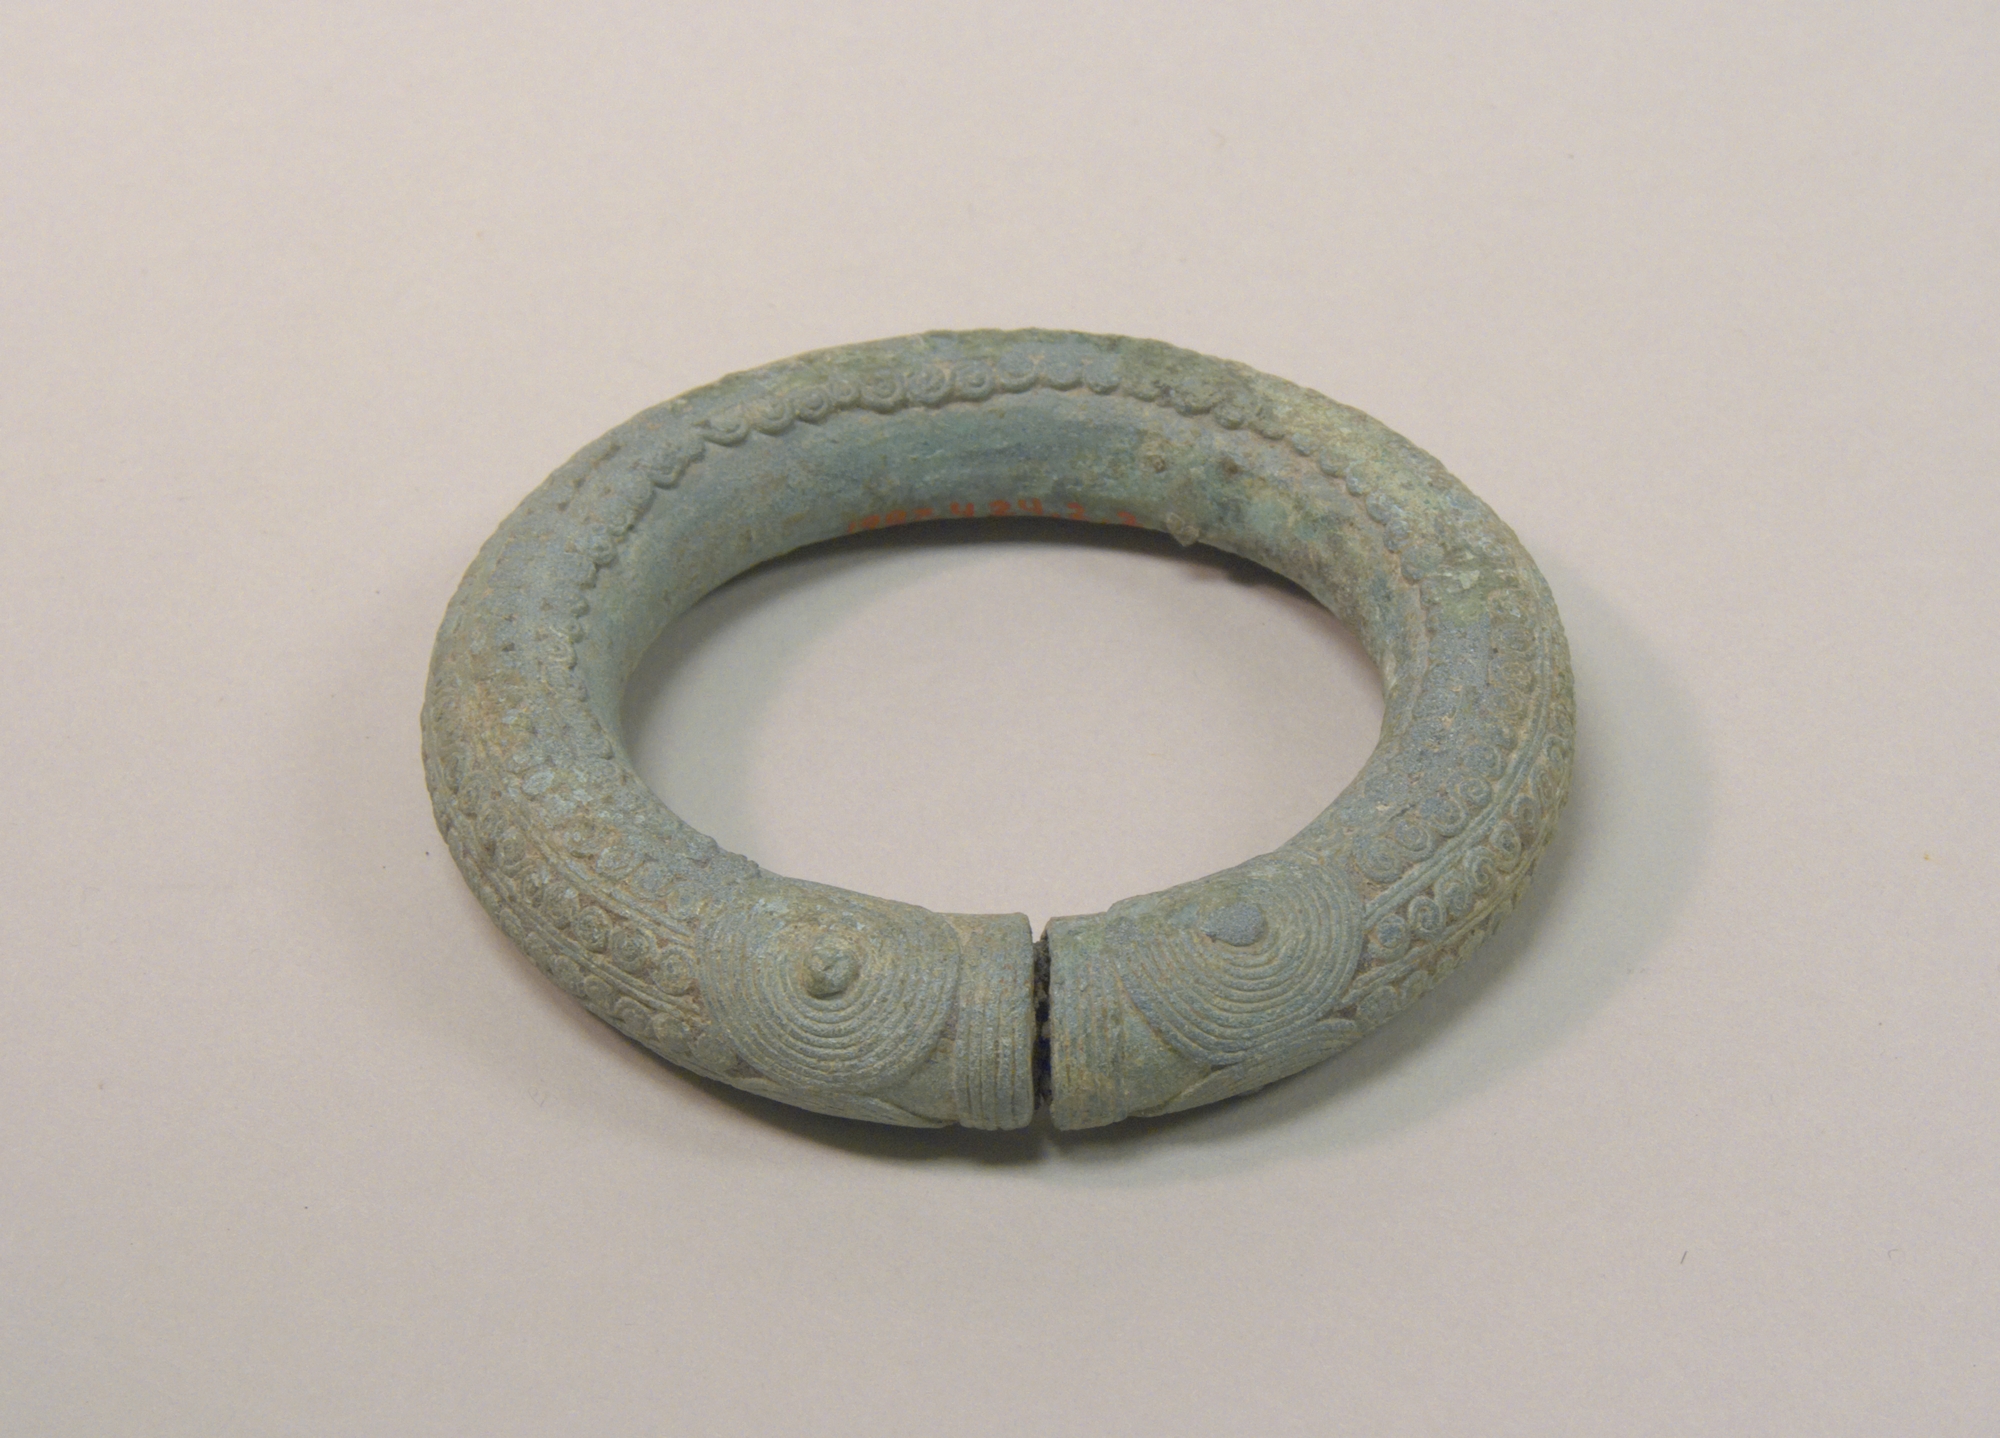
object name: bracelet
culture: thai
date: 500 BCE-300 CE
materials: bronze